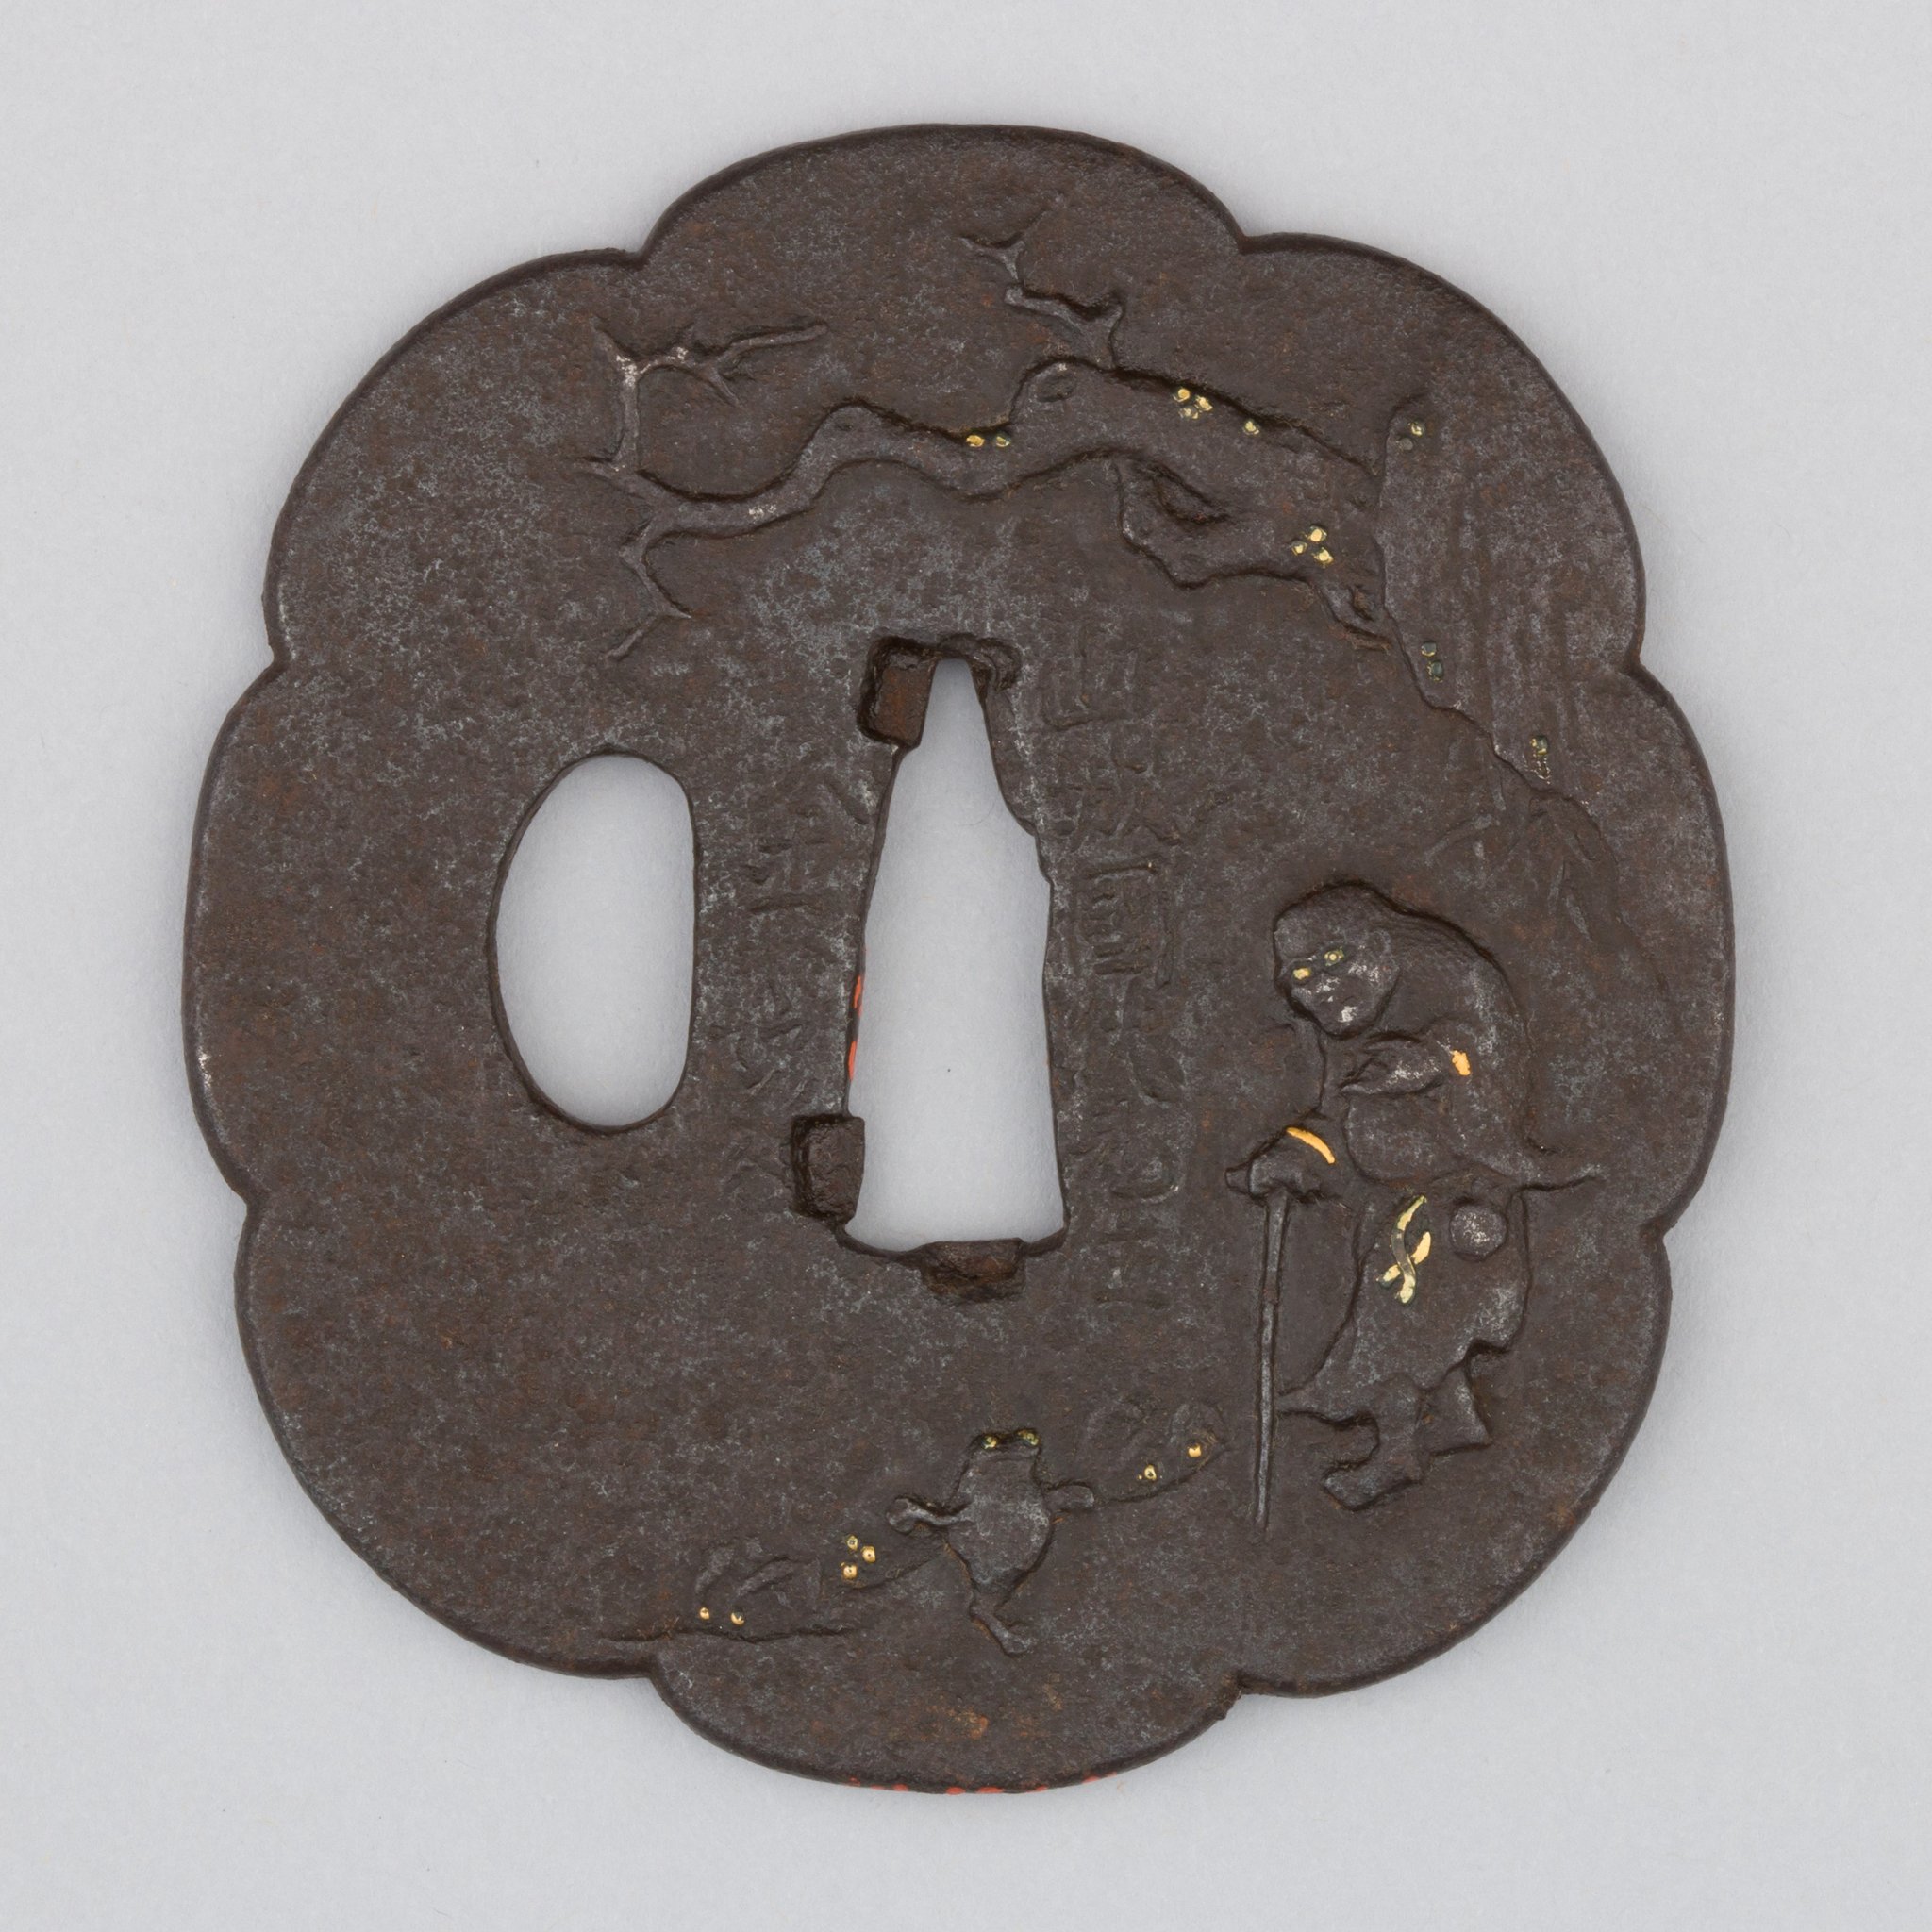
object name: sword guard tsuba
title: Sword Guard (Tsuba)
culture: japanese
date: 1701-1800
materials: gold, iron, silver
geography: japan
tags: human figures,frogs